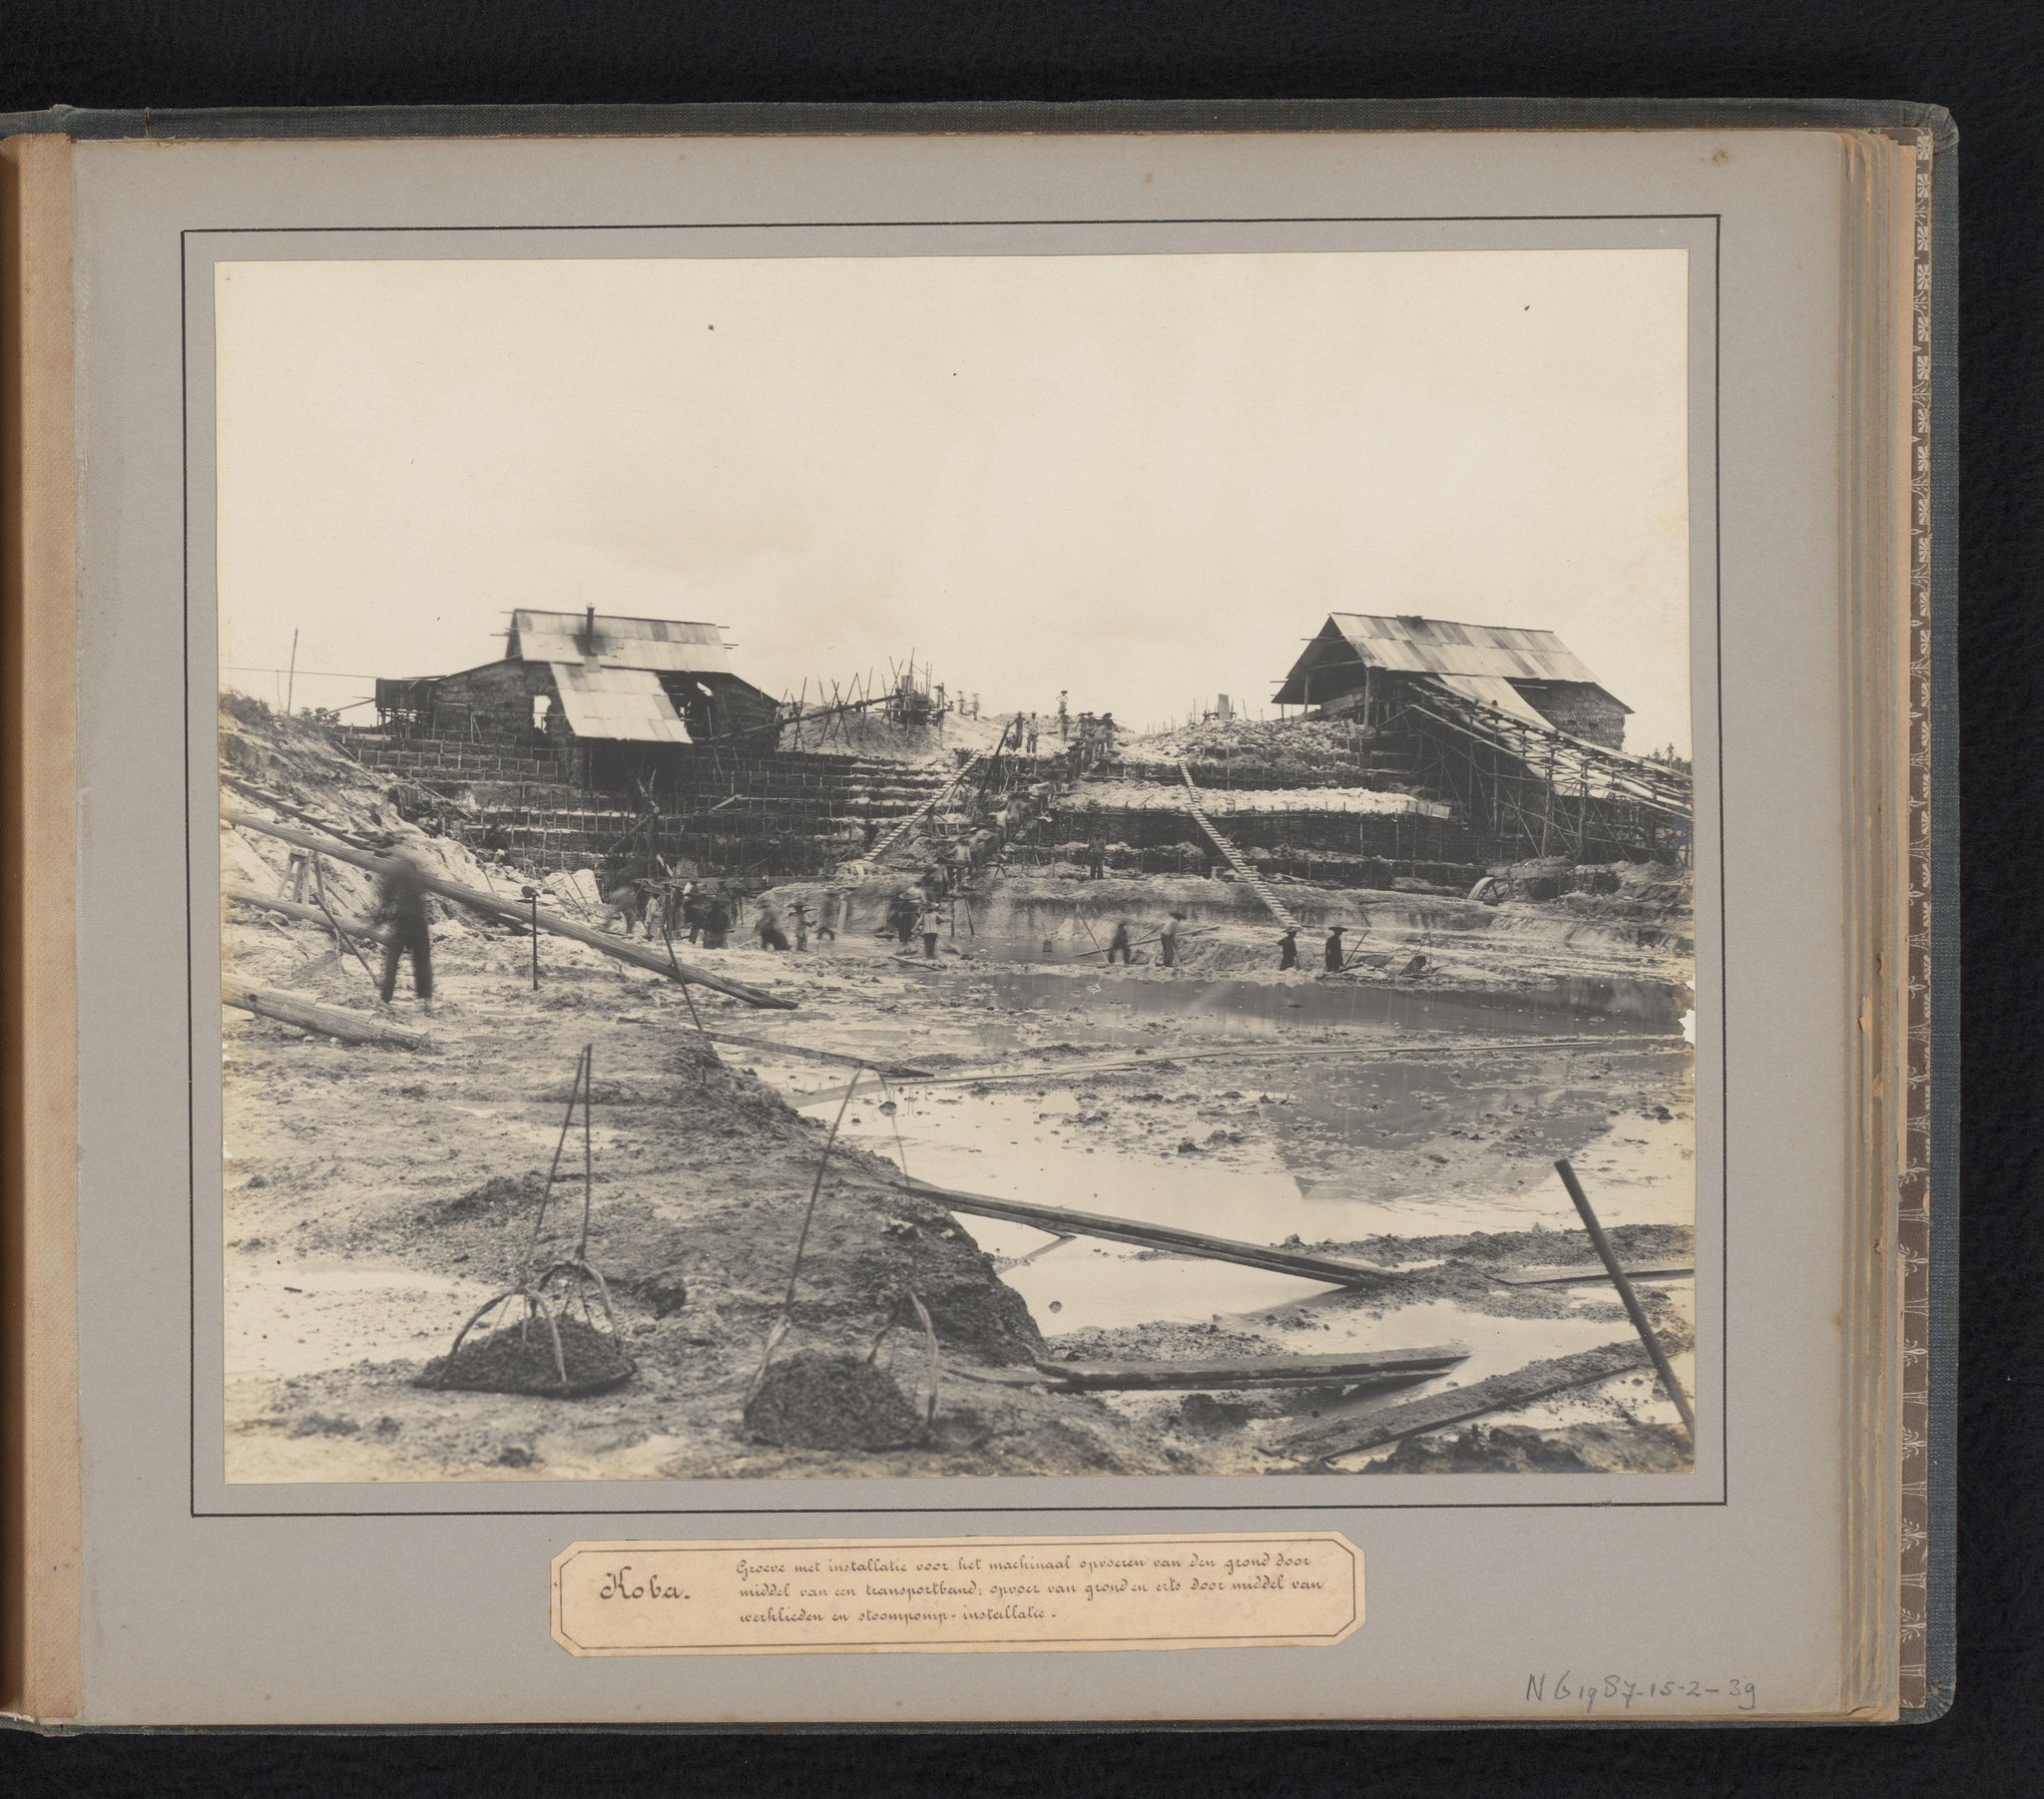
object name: photograph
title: Koba. Groeve met installatie voor het machinaal opvoeren van den grond door middel van een transportband; opvoer van grond en erts door middel van werklieden en stoompomp-installatie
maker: Anonymous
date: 1909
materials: cardboard, photographic support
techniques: gelatin silver print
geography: bangka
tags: robert julius boers, colonial system, opencast mine; strip mining, minerals and metals: tin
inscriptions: label: ‘Koba. Groeve met installatie voor het machinaal opvoeren van den grond door middel van een transportband; opvoer van grond en erts door middel van werklieden en stoompomp-installatie’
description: De groeve van een open tinmijn van de Banka-tinwinning te Koba, met gemechaniseerde en handmatige afvoer van afgegraven ertsgrond. Onderdeel van het fotoalbum over de Banka-tinwinning, ca. 1907-1919.